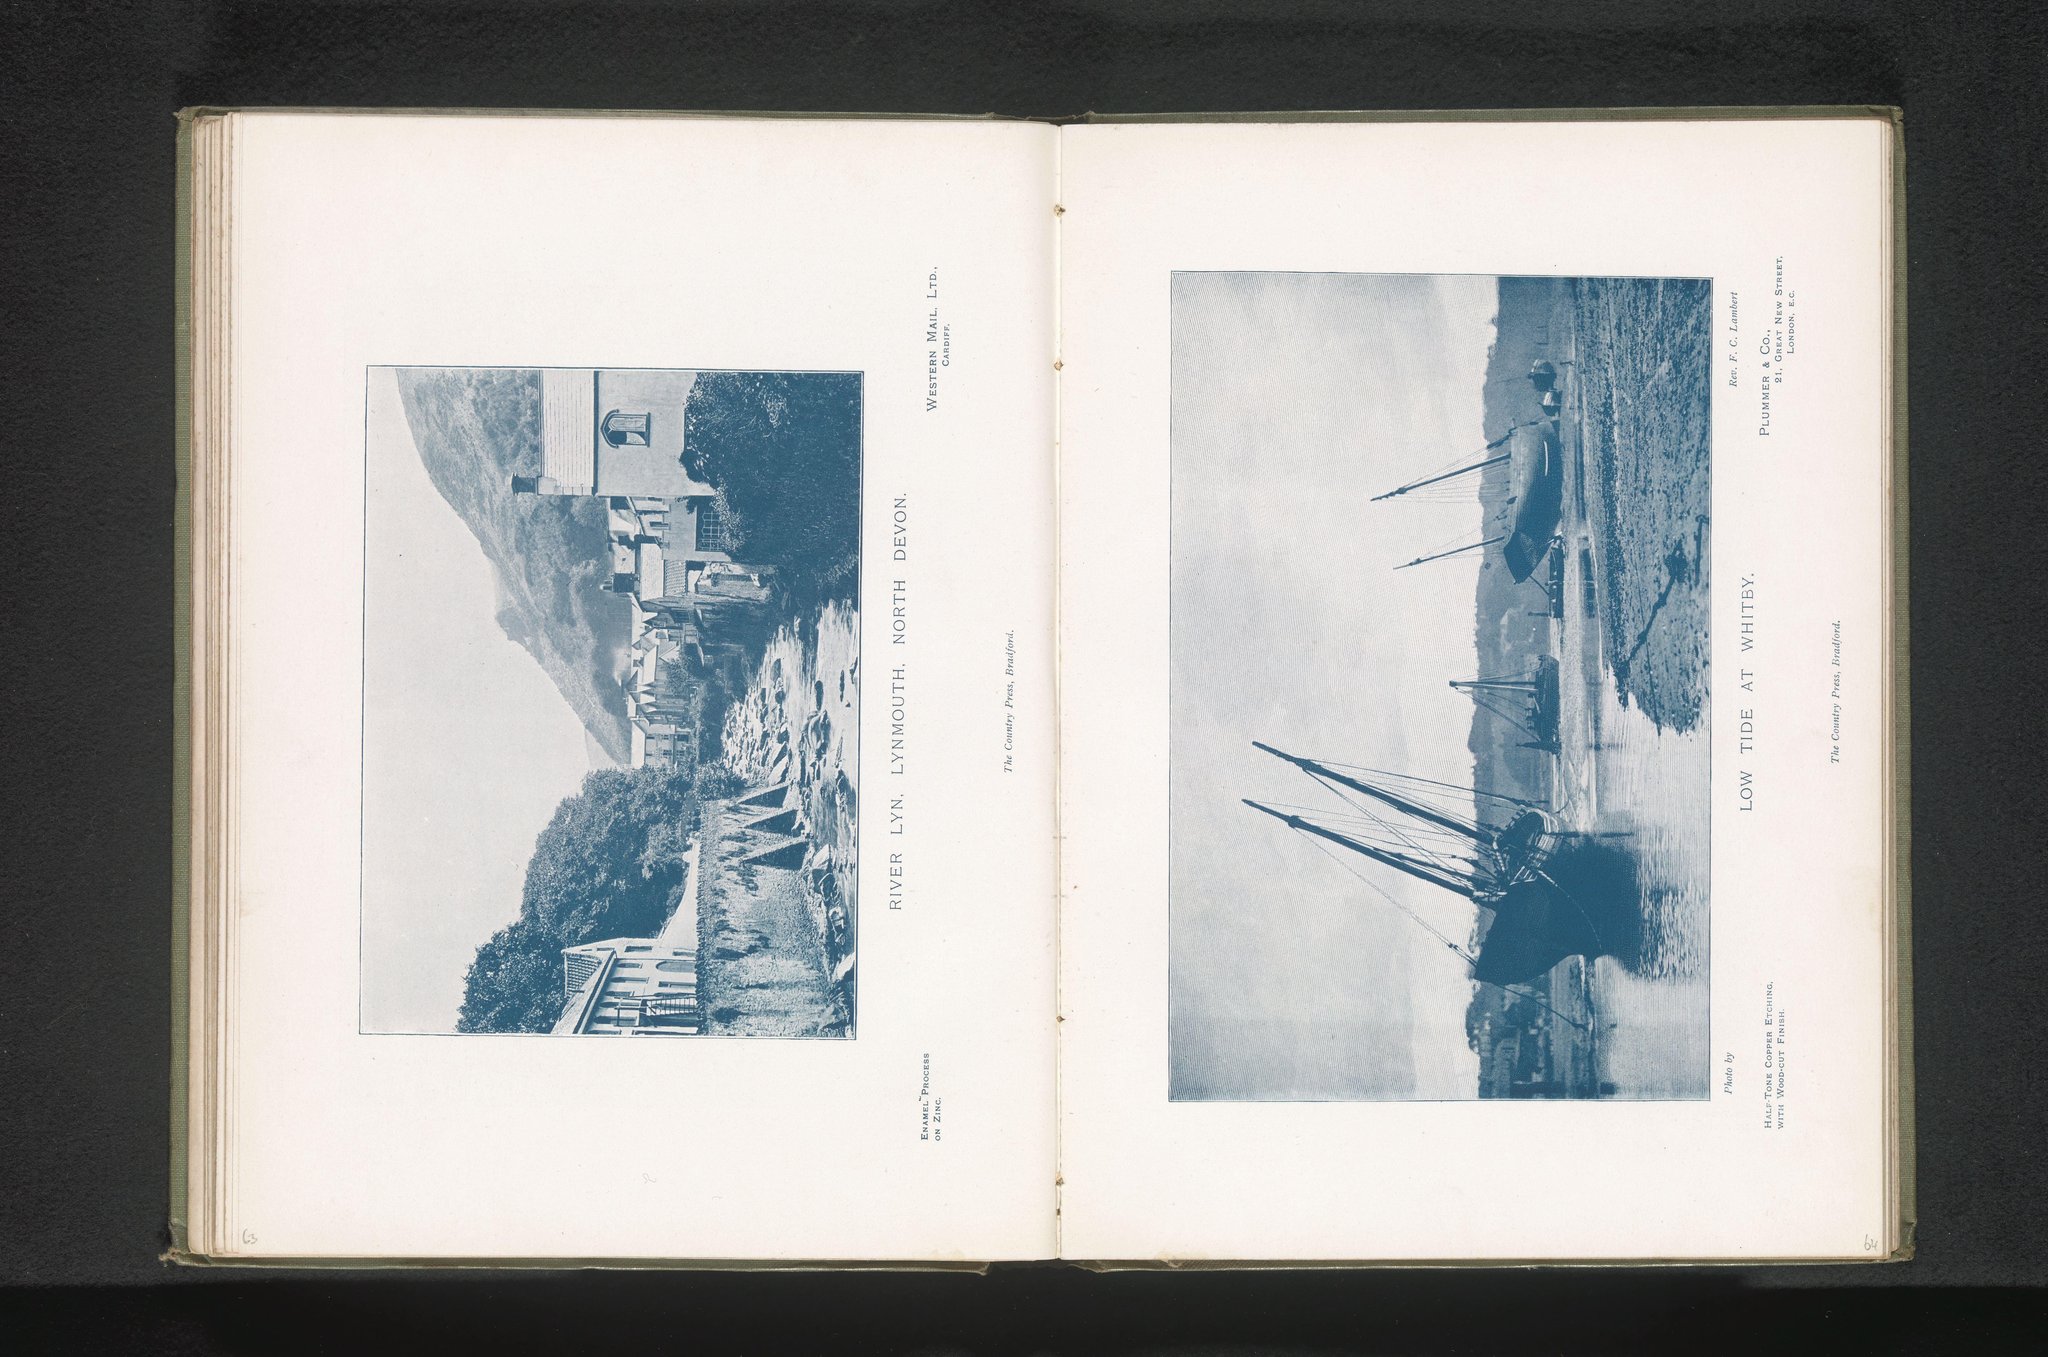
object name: photomechanical print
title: Gezicht op Lynmouth met de Lyn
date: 1893-1898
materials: paper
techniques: autotype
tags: city-view in general; 'veduta', river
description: Prent op zesde ongenummerde pagina na pagina 80.